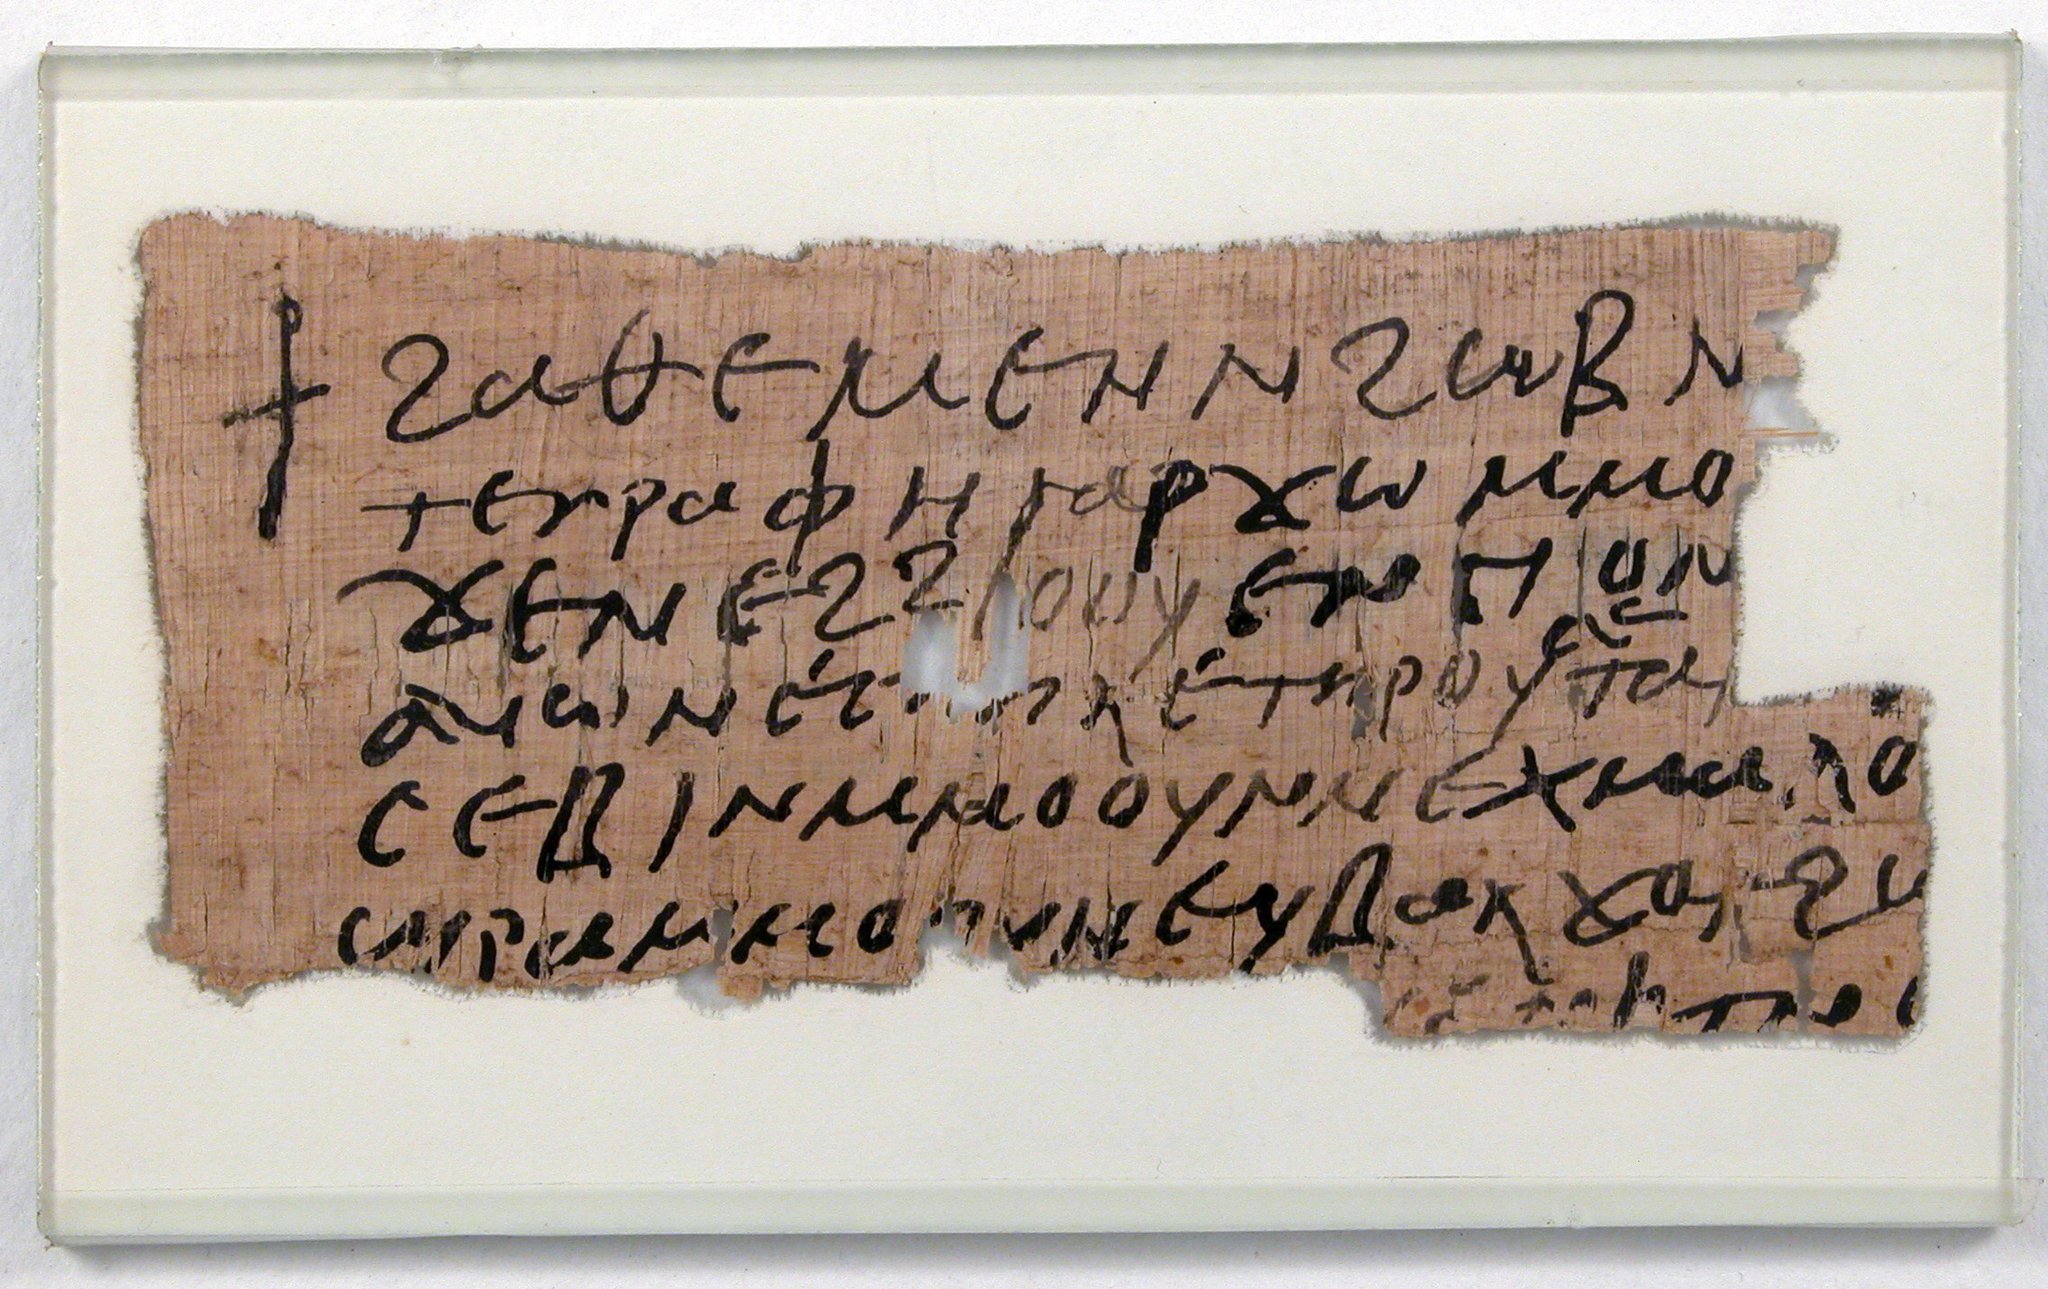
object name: papyrus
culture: coptic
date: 601-700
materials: ink, papyrus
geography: egypt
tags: documents